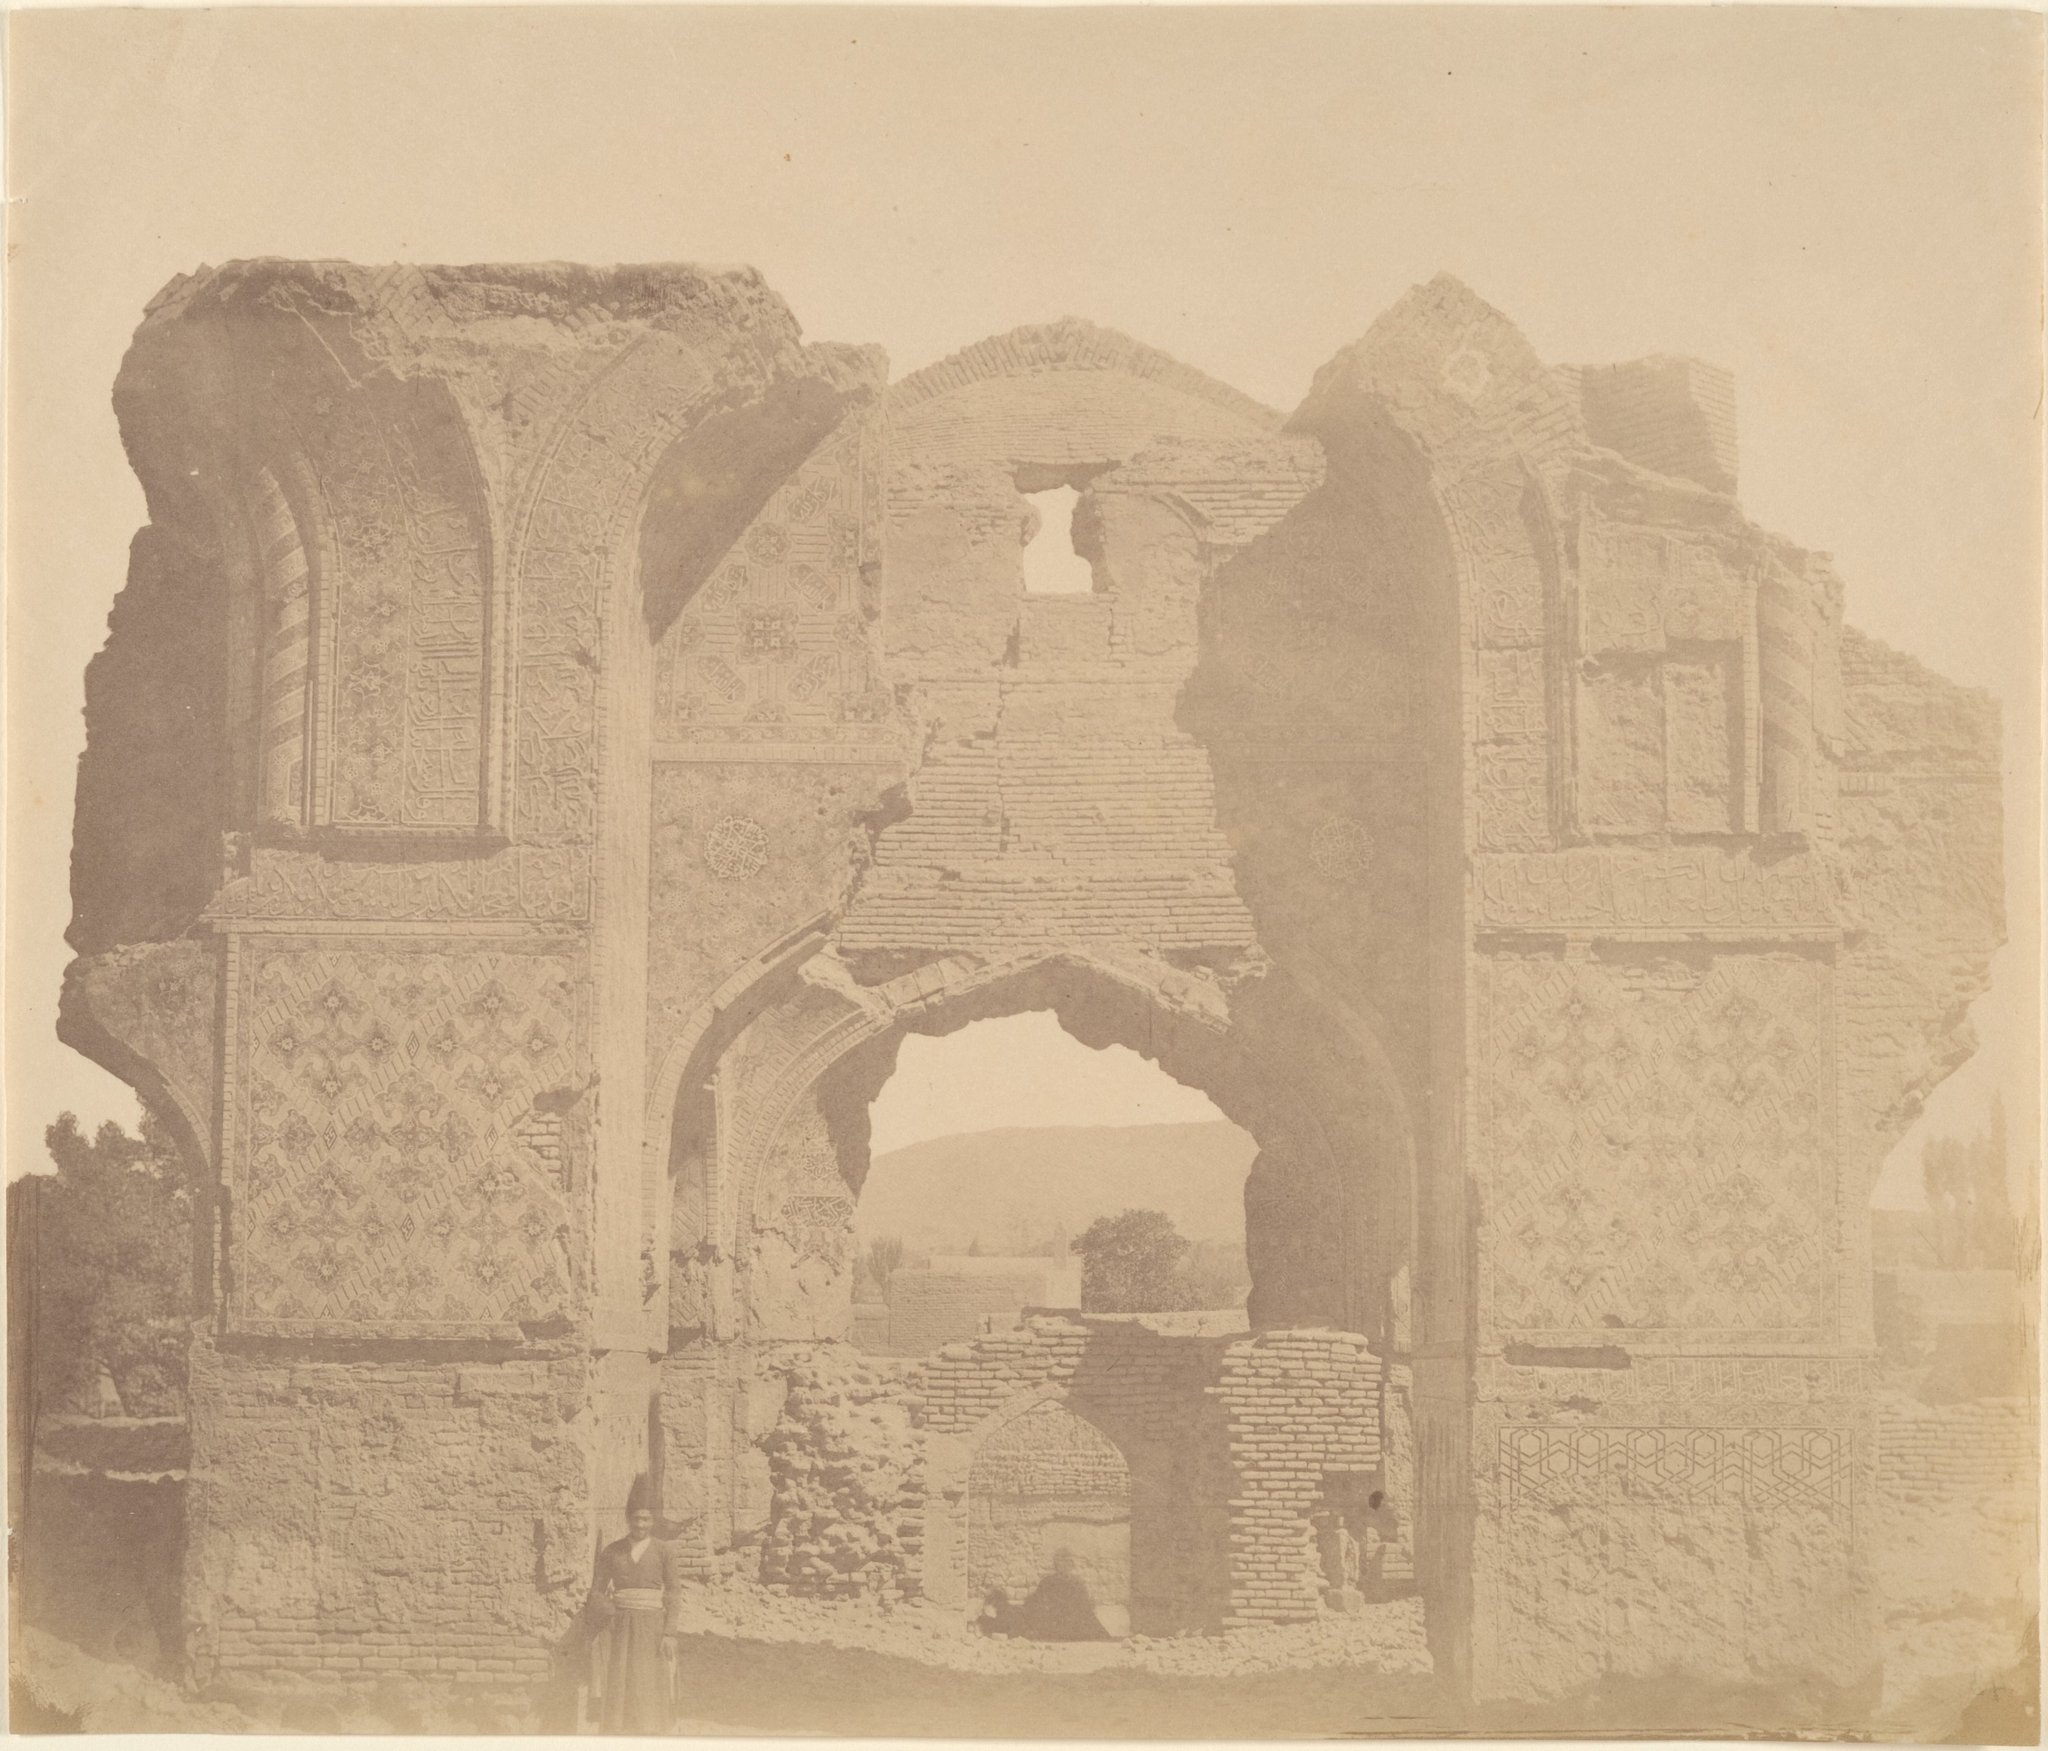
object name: photograph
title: [Blue Mosque of TABRIZ, 1465.]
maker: luigi pesce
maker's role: artist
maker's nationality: italian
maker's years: 1818-1891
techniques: albumen silver print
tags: architecture,mosques,ruins